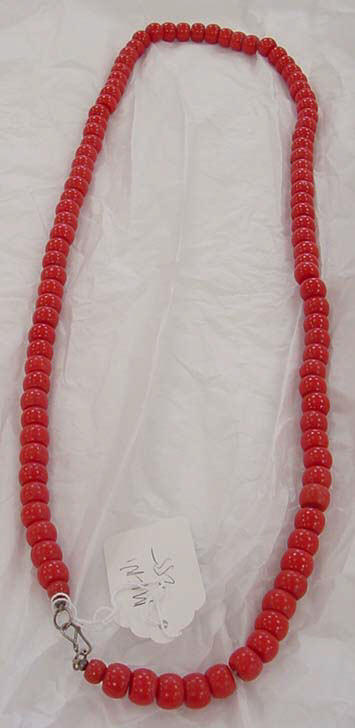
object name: necklace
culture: chinese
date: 1644-1911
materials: cotton, glass, metal